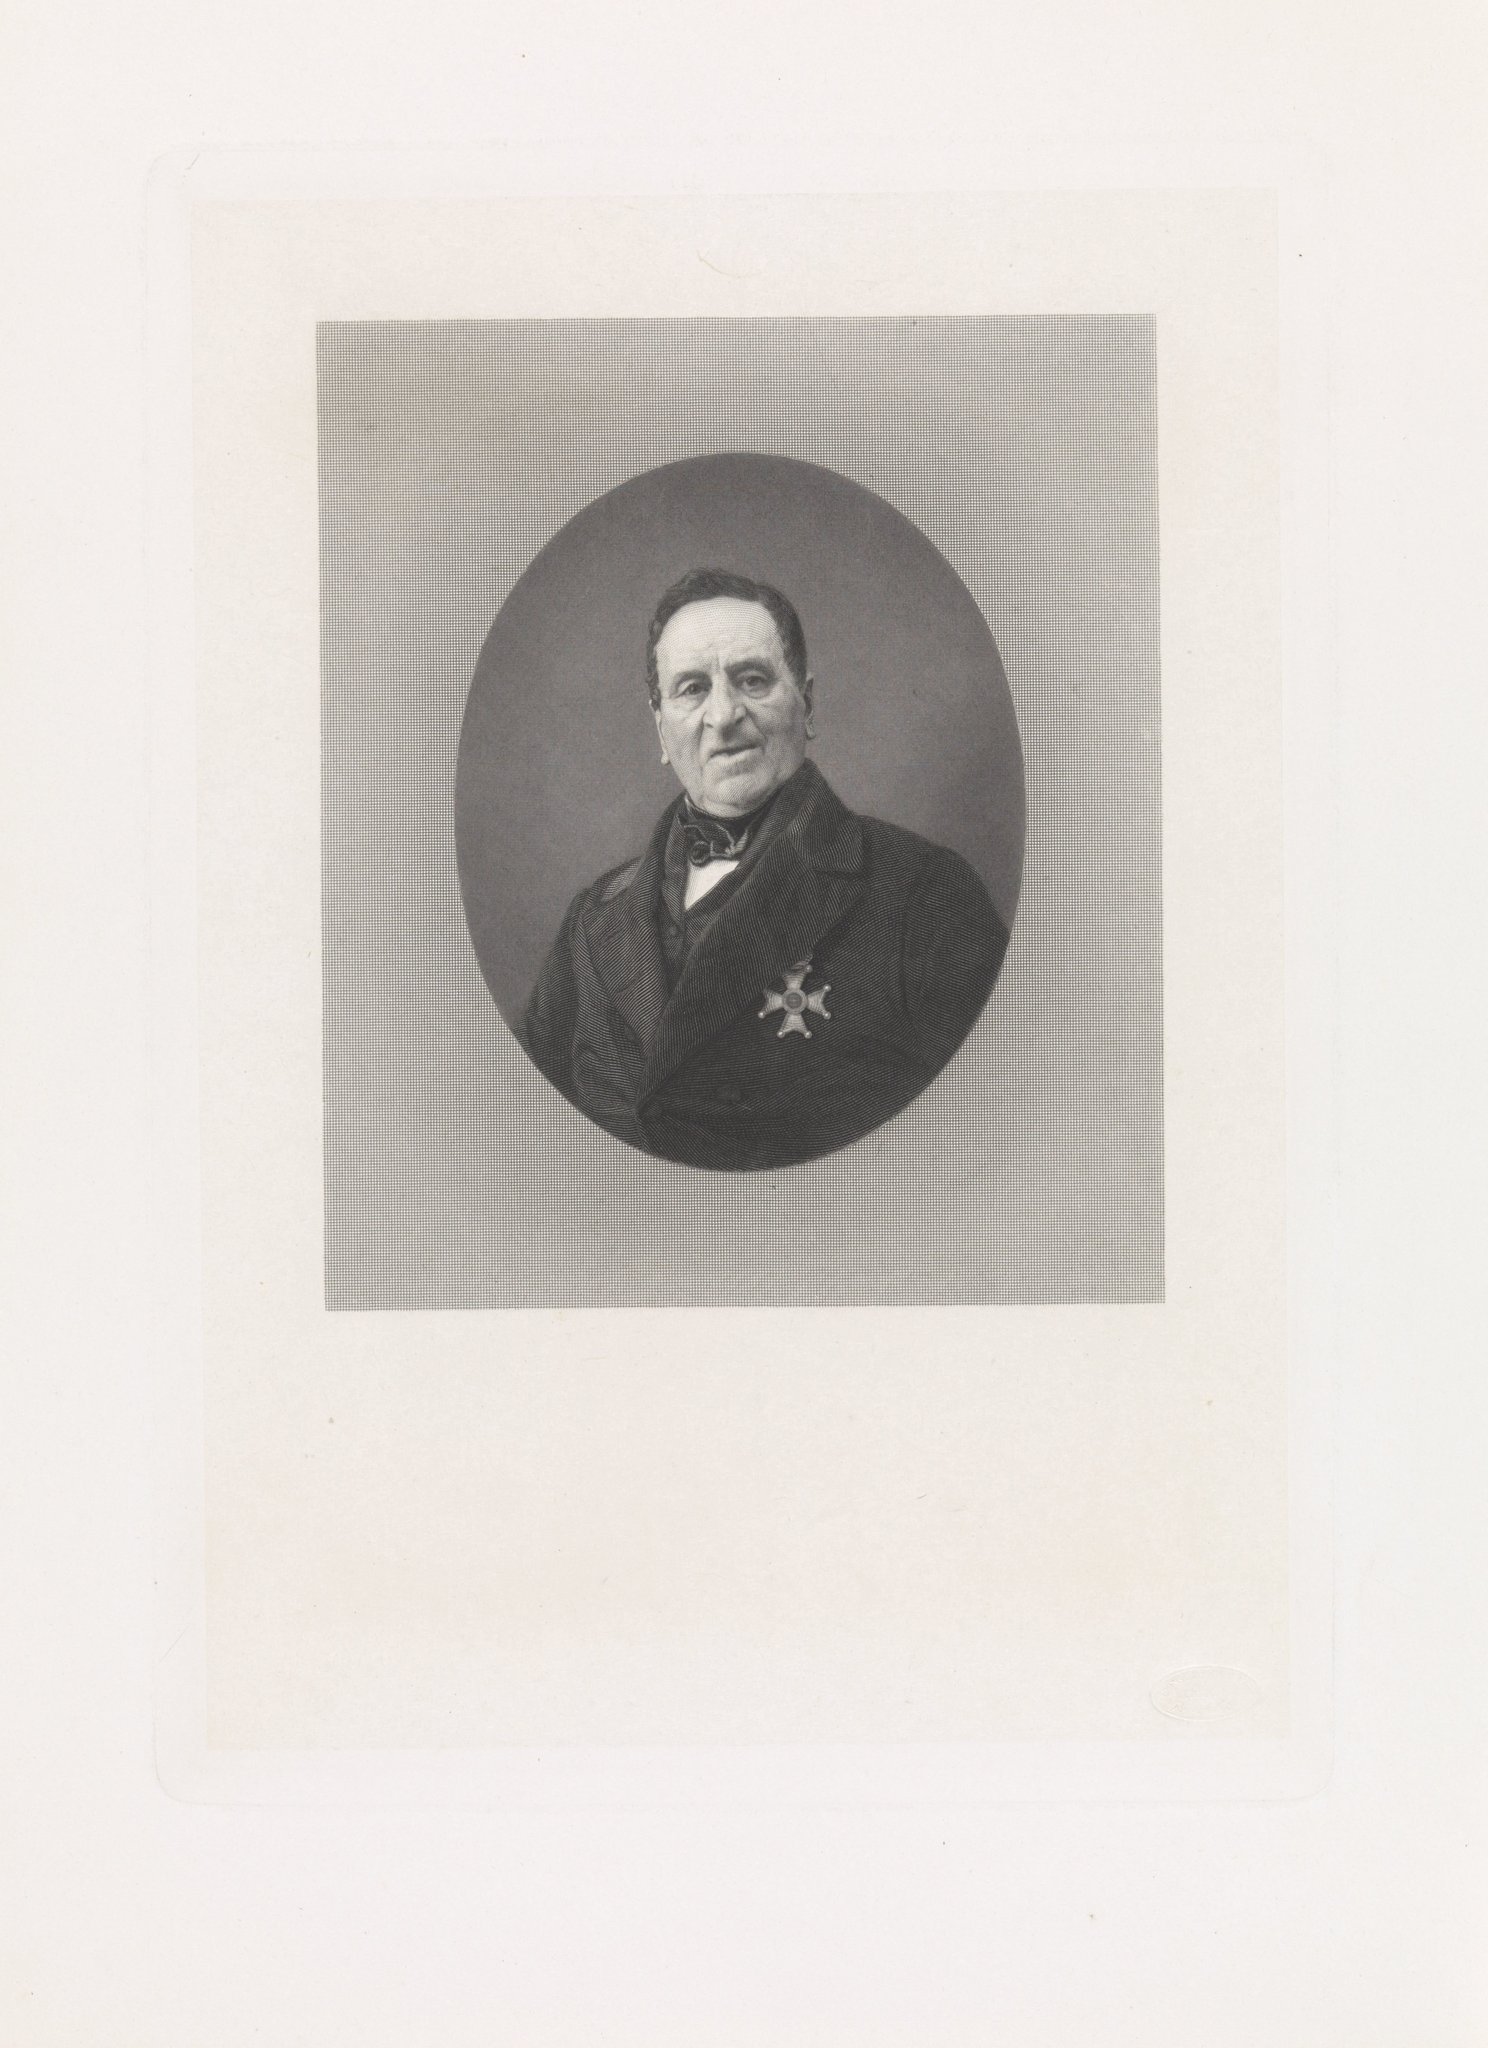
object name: print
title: Portret van de Rotterdamse dichter en koopman Hendrik Tollens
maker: benoit taurel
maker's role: draughtsman, print maker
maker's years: 1794-1859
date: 1856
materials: paper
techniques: engraving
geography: amsterdam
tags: rotterdam, hendrik tollens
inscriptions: collector's mark: Lugt 12, check stamp: ‘Frans Buffa en Zonen uitgevers Amsterdam’